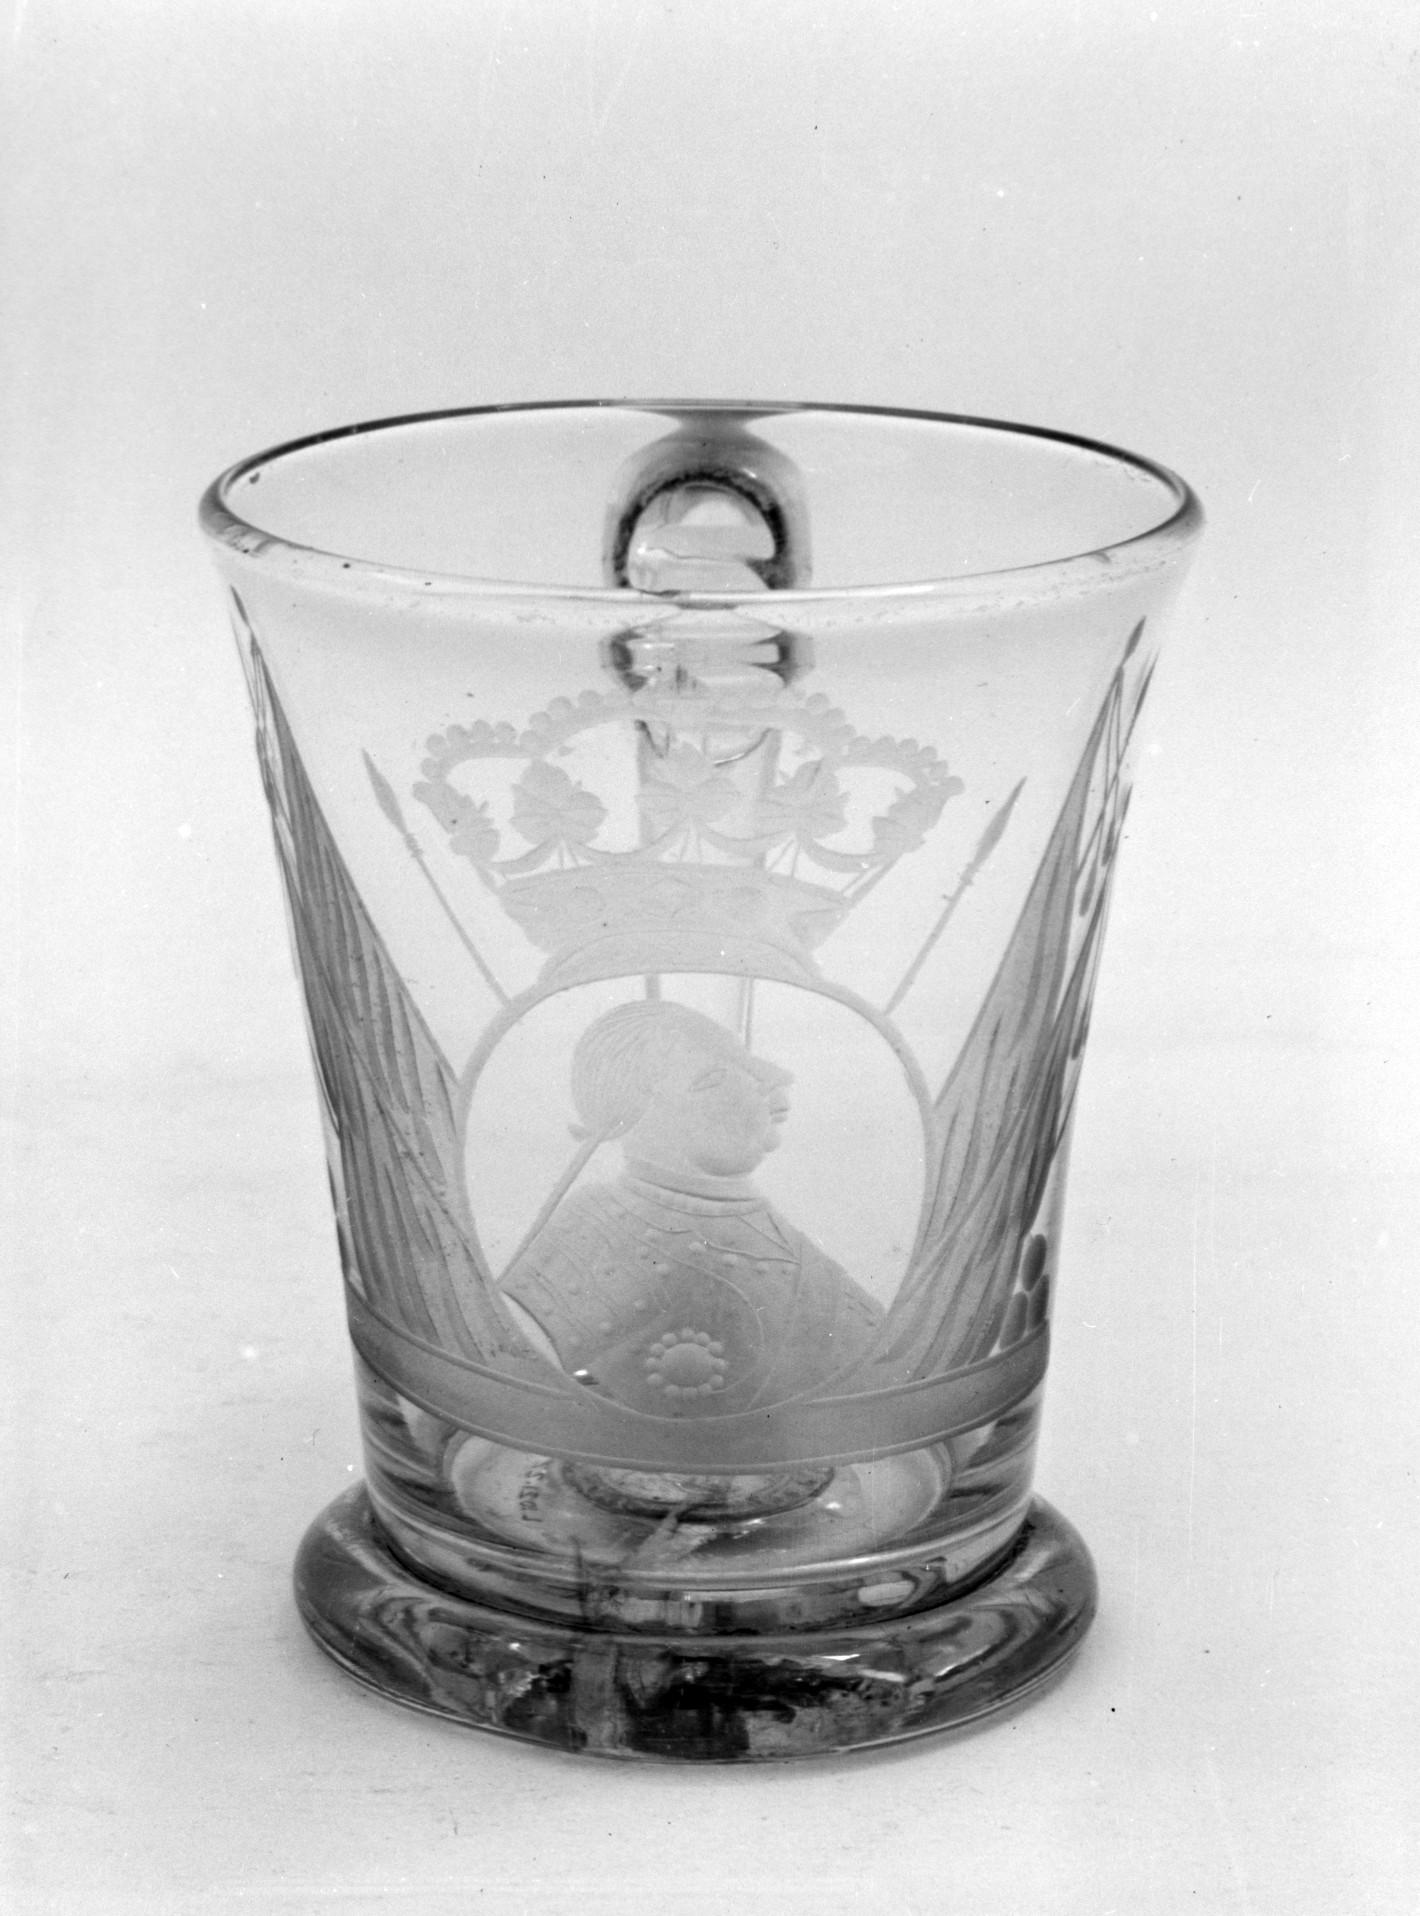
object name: mug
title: Mug with portrait of Frederick I (1688–1740), King of Prussia (1713–40)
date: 1700-1740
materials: glass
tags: kings,men,profiles